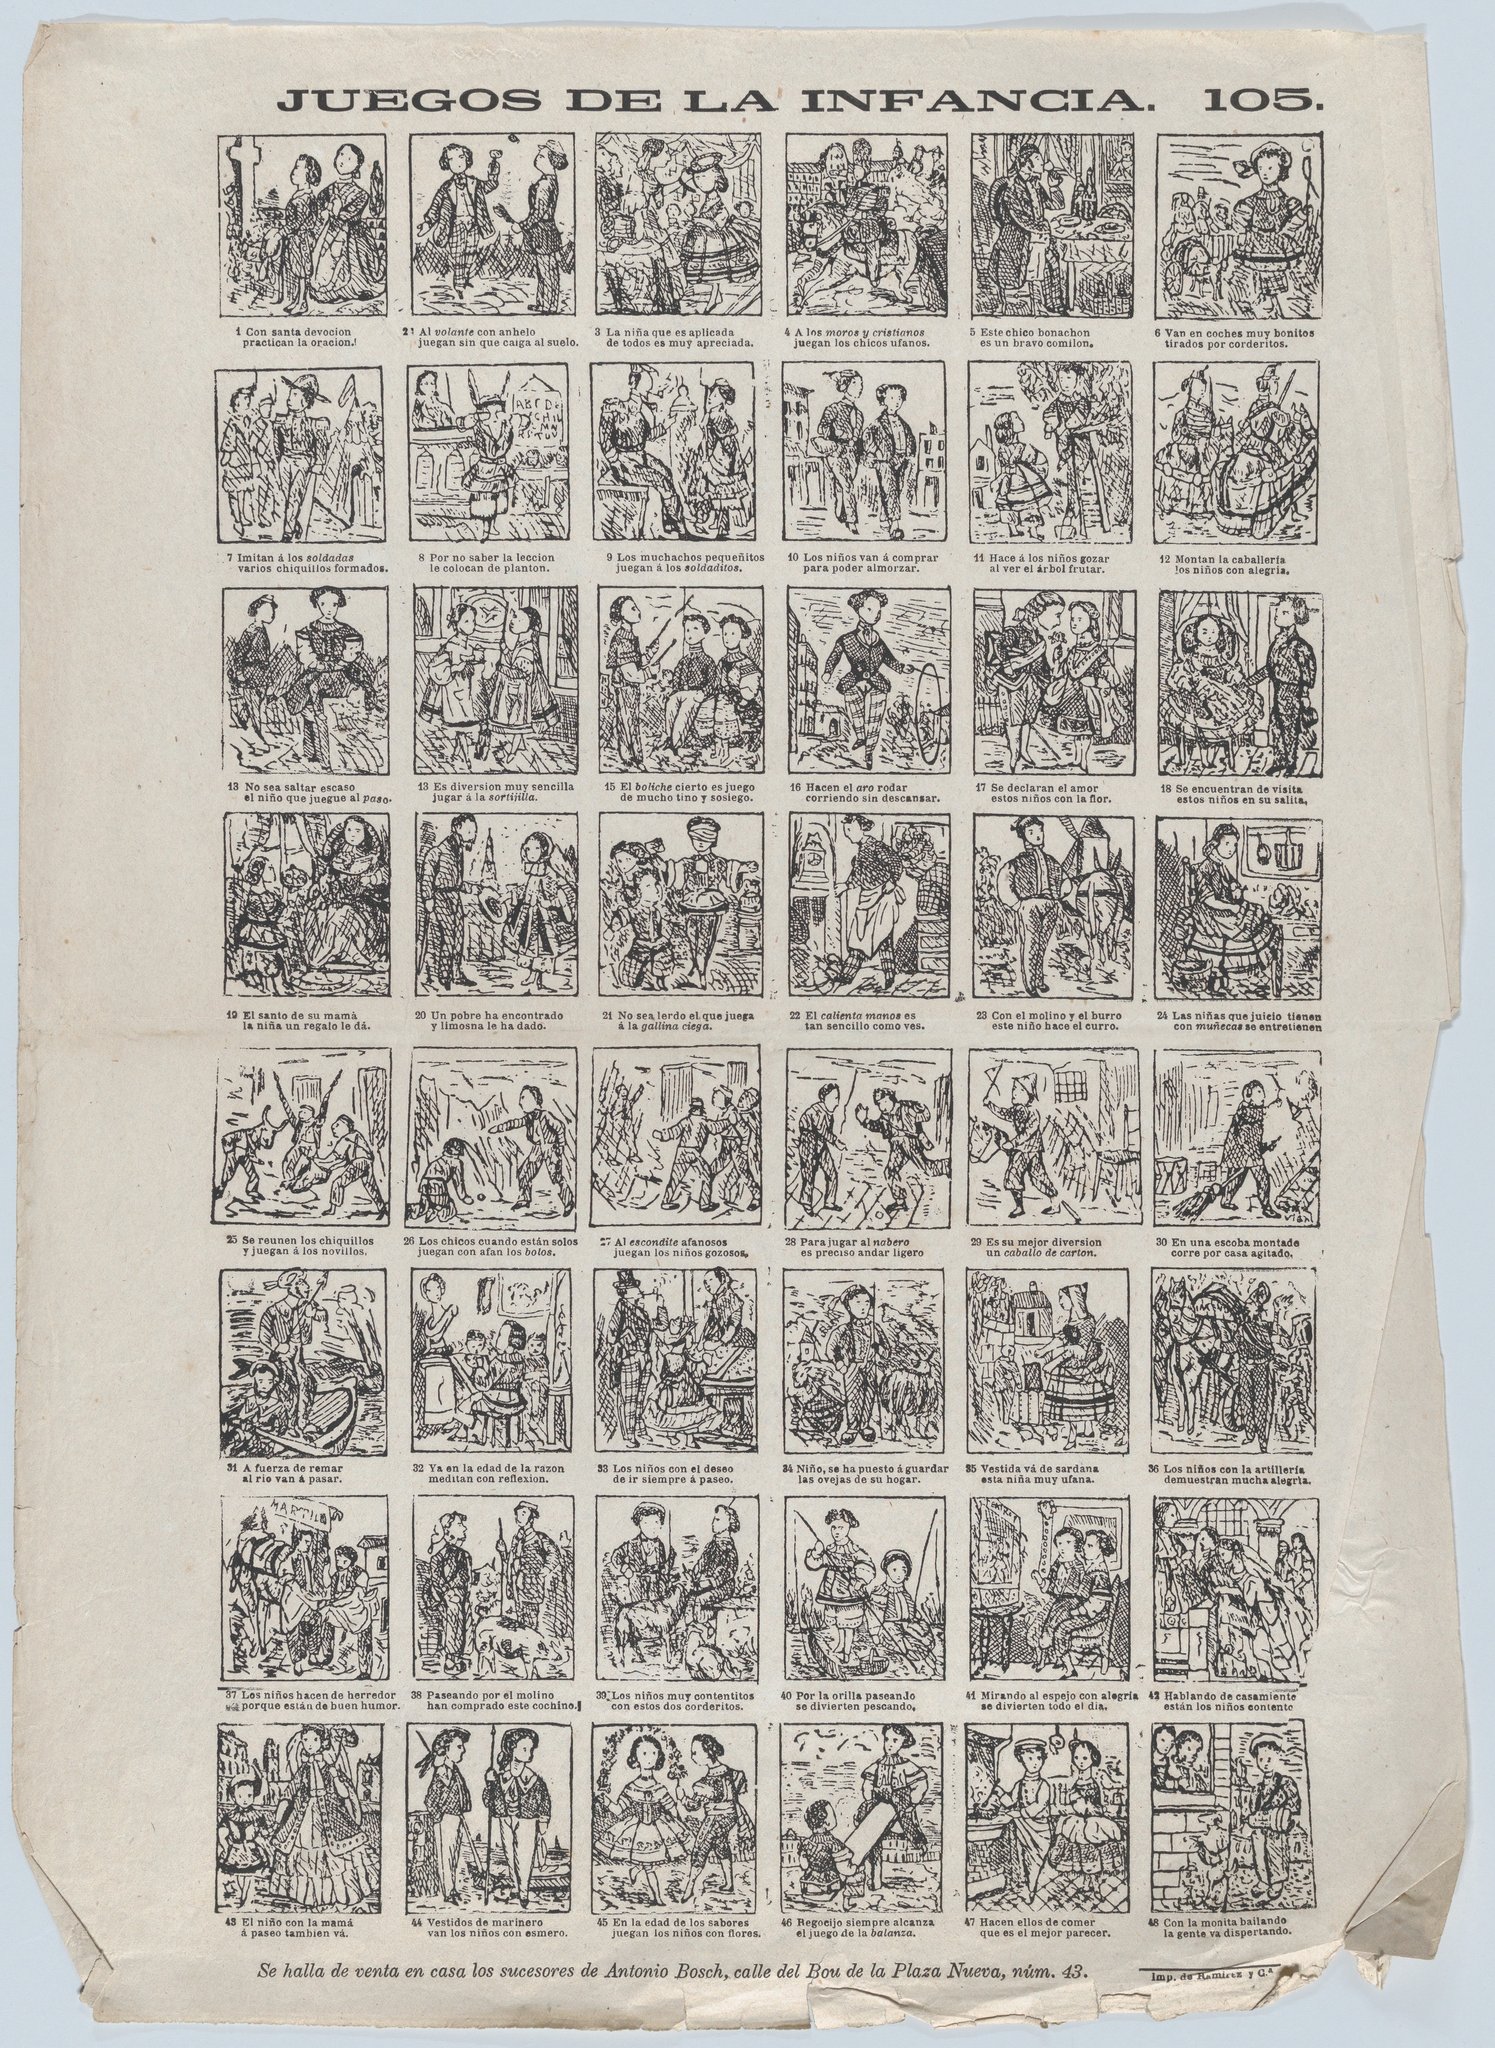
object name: print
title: A childrens game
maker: antonio bosch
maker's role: publisher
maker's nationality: spanish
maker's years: 1860-1880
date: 1860-1870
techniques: etching, relief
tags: men,women